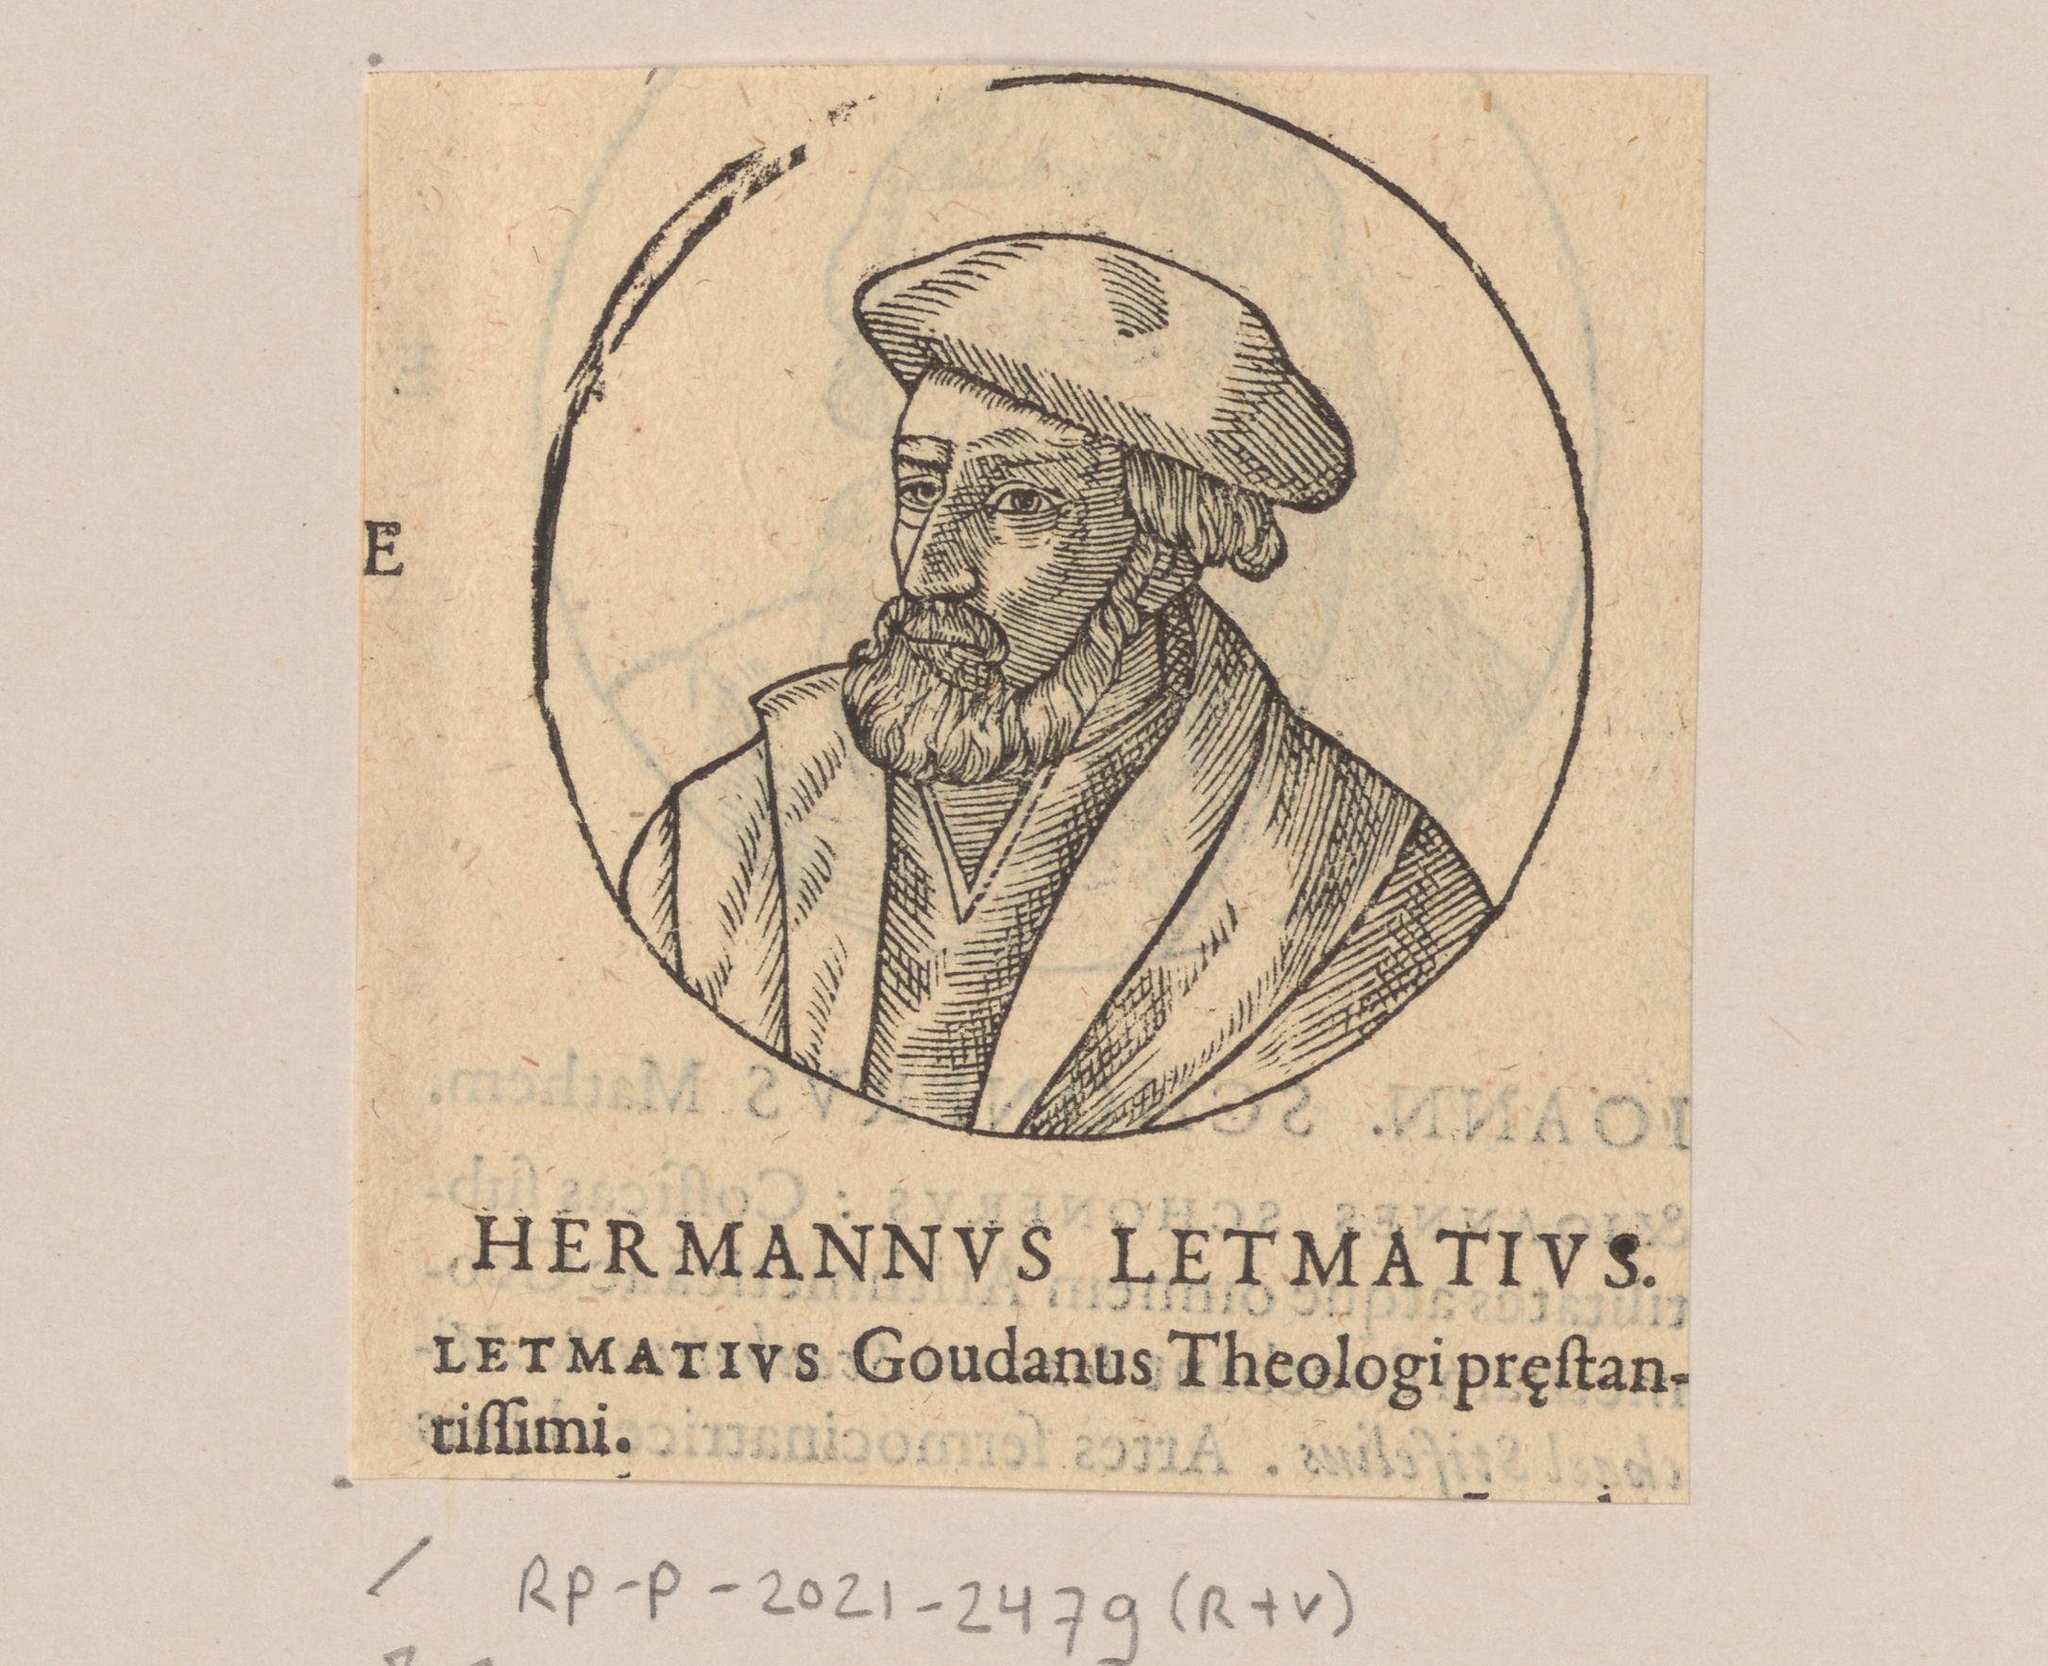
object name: print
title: Portret van Herman Lethmaet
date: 1611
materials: paper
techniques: letterpress printing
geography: southern netherlands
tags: gouda, theologian, historical persons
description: Prent uit: Opmeer, Pieter van. Opus chronographicum orbis universi a mundi exordio (...). Antwerpen: Hieronymus Verdussen, 1611, p. 480.